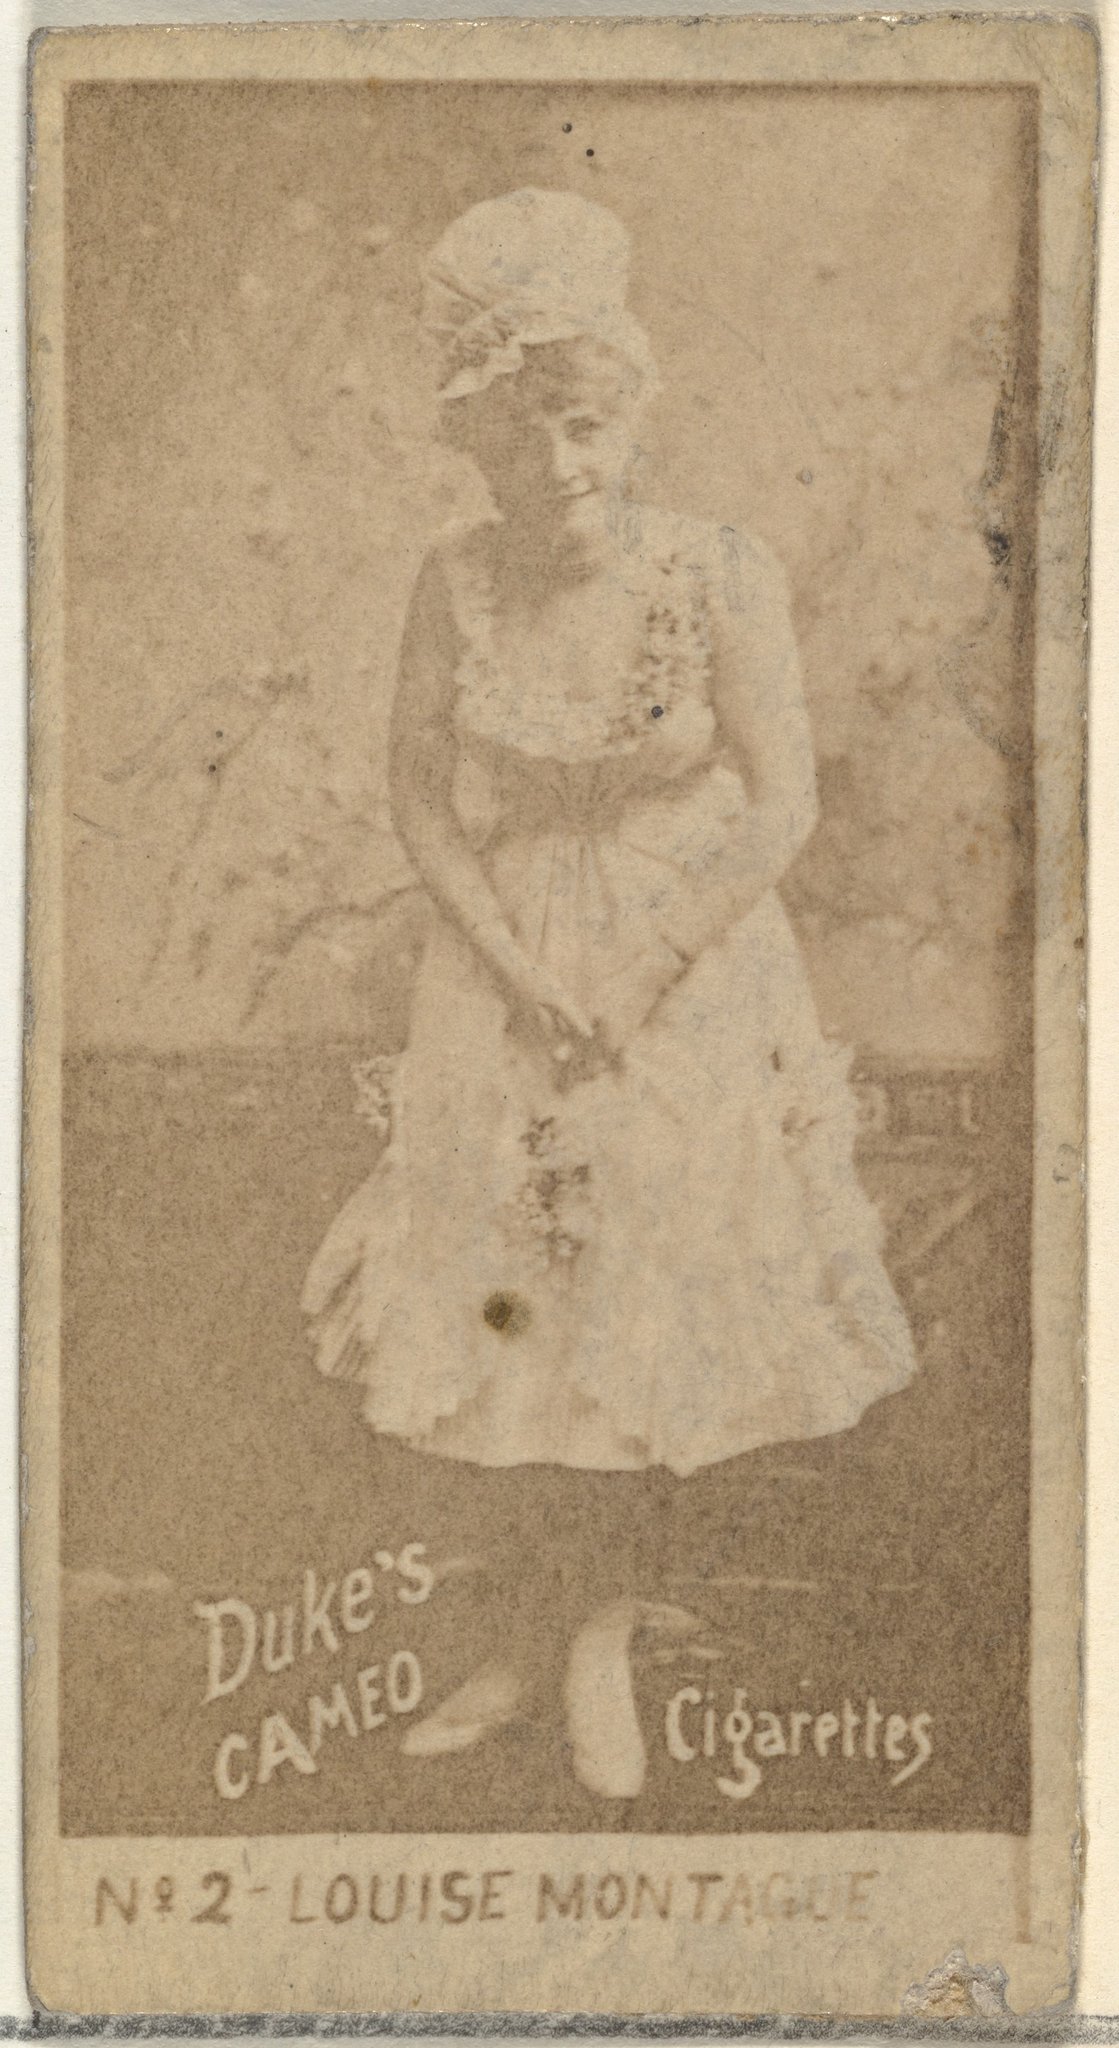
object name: photograph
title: Card Number 2, Louise Montague, from the Actors and Actresses series (N145-4) issued by Duke Sons & Co. to promote Cameo Cigarettes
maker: w. duke, sons & co.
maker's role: publisher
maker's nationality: american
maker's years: 1870-1920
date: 1880-1889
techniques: albumen silver print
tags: portraits,women,actresses